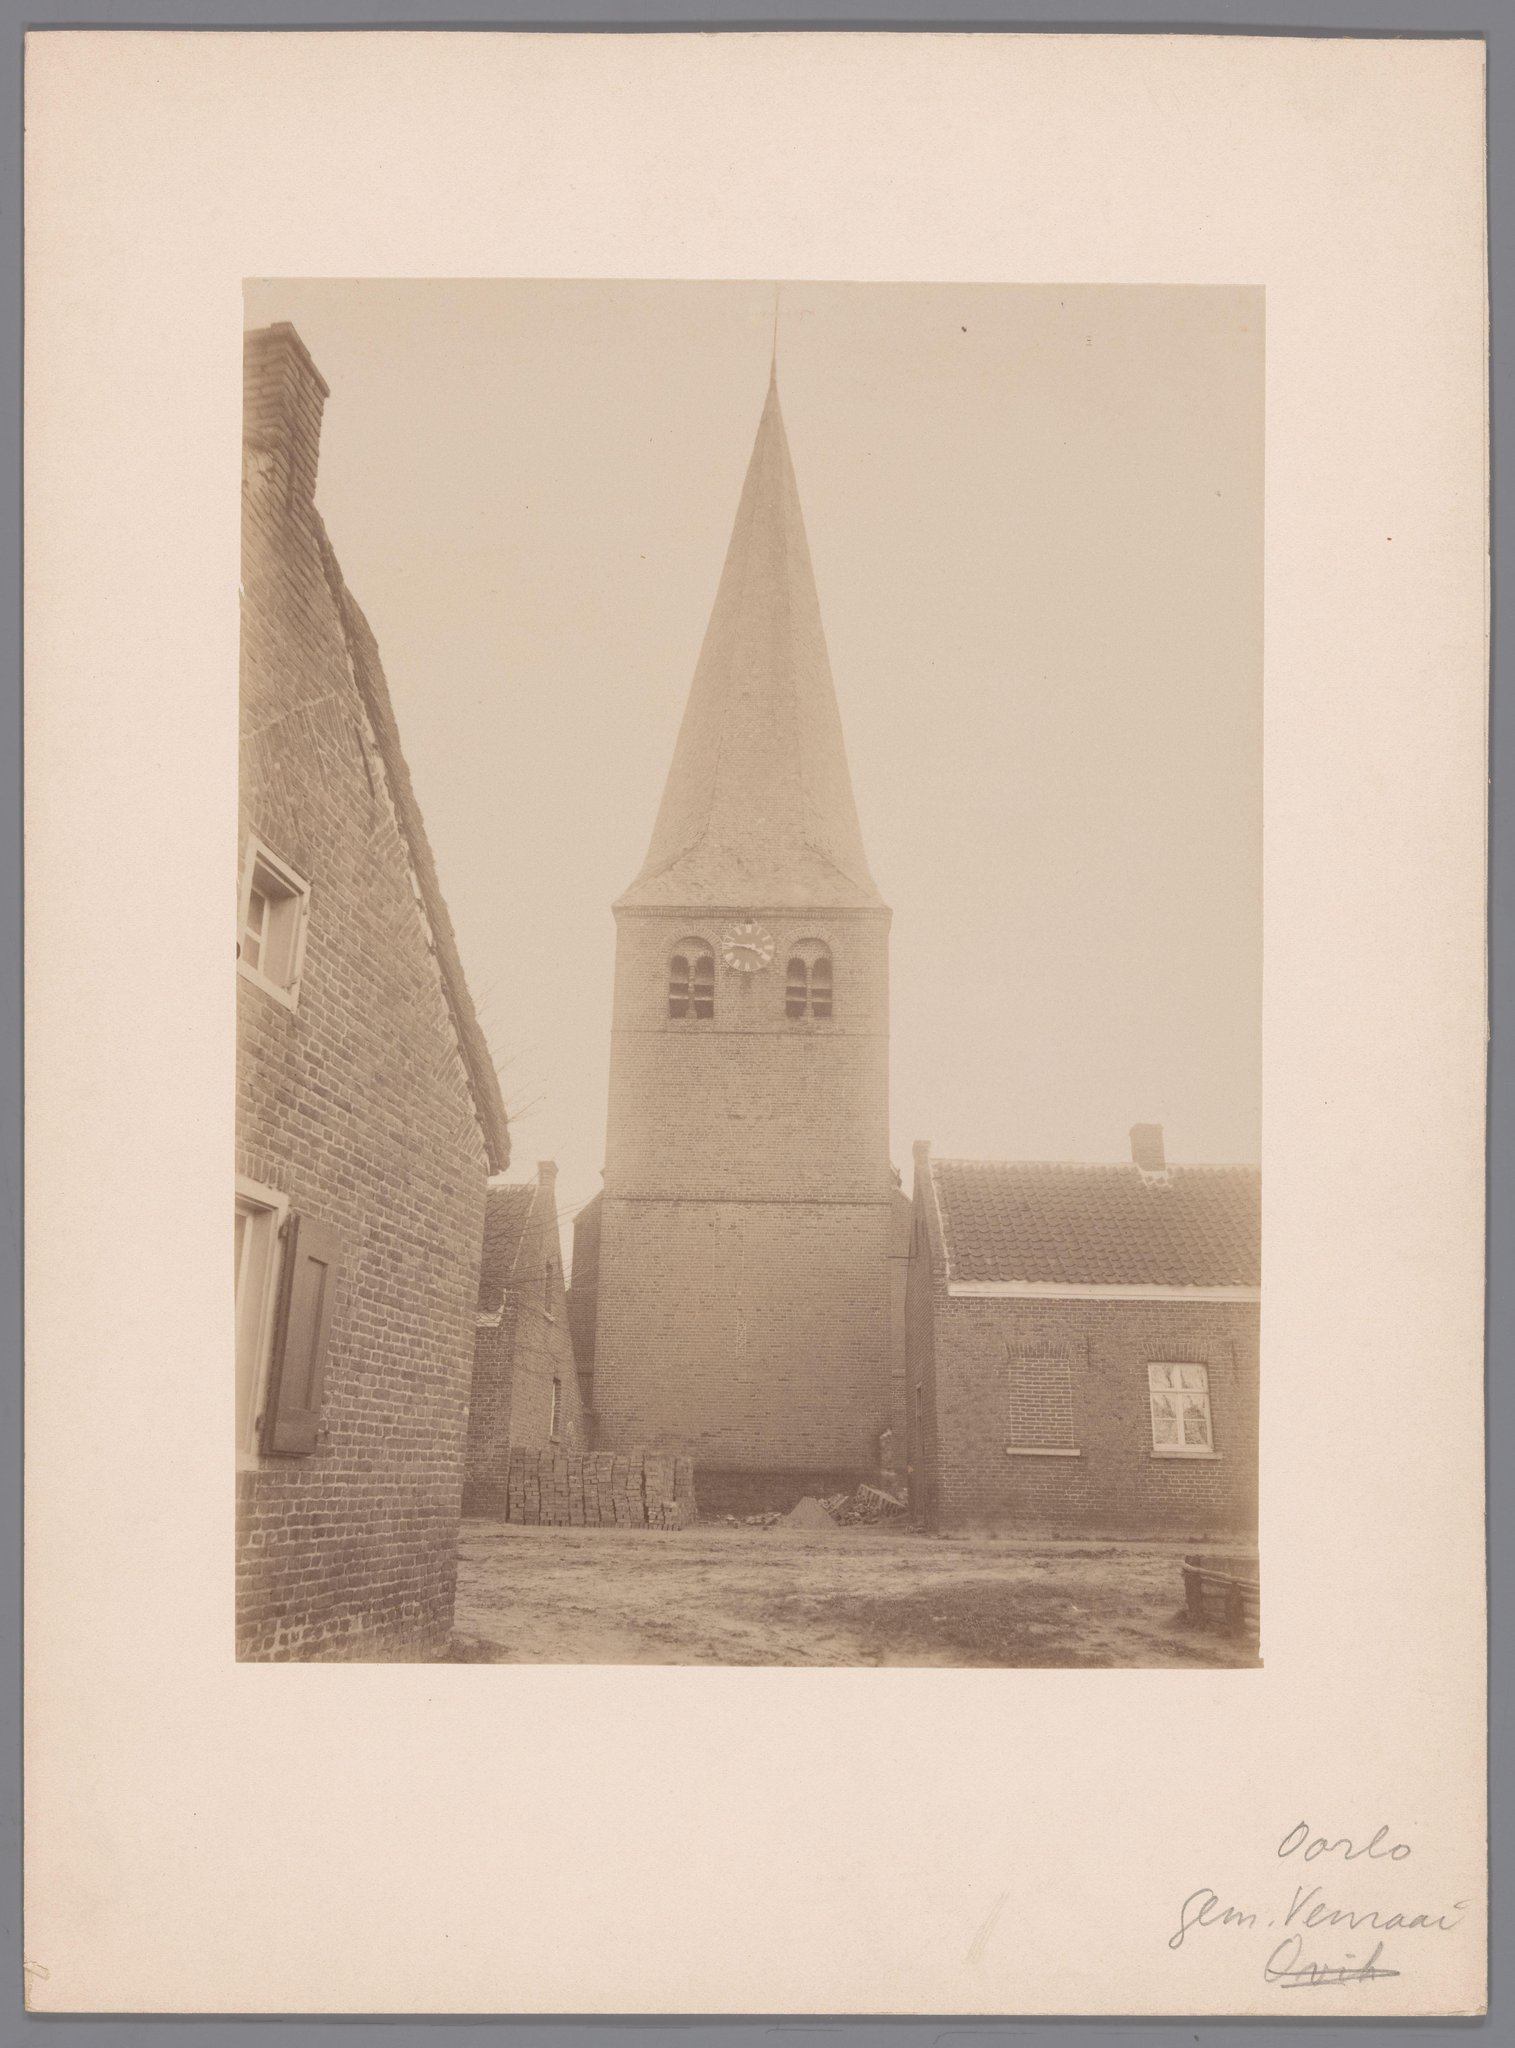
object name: photograph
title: Toren van de Sint-Gertrudiskerk te Oirle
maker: anoniem (monumentenzorg)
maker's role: fotograaf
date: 1904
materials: cardboard, photographic support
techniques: albumen print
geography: venray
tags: parts of church exterior and annexes: tower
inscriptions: annotation: ‘Oirle gemeente Venraai (Limburg)/ R.K. Kerk/ feb 1904’, annotation: ‘Oorlo/ gem. Venraai’